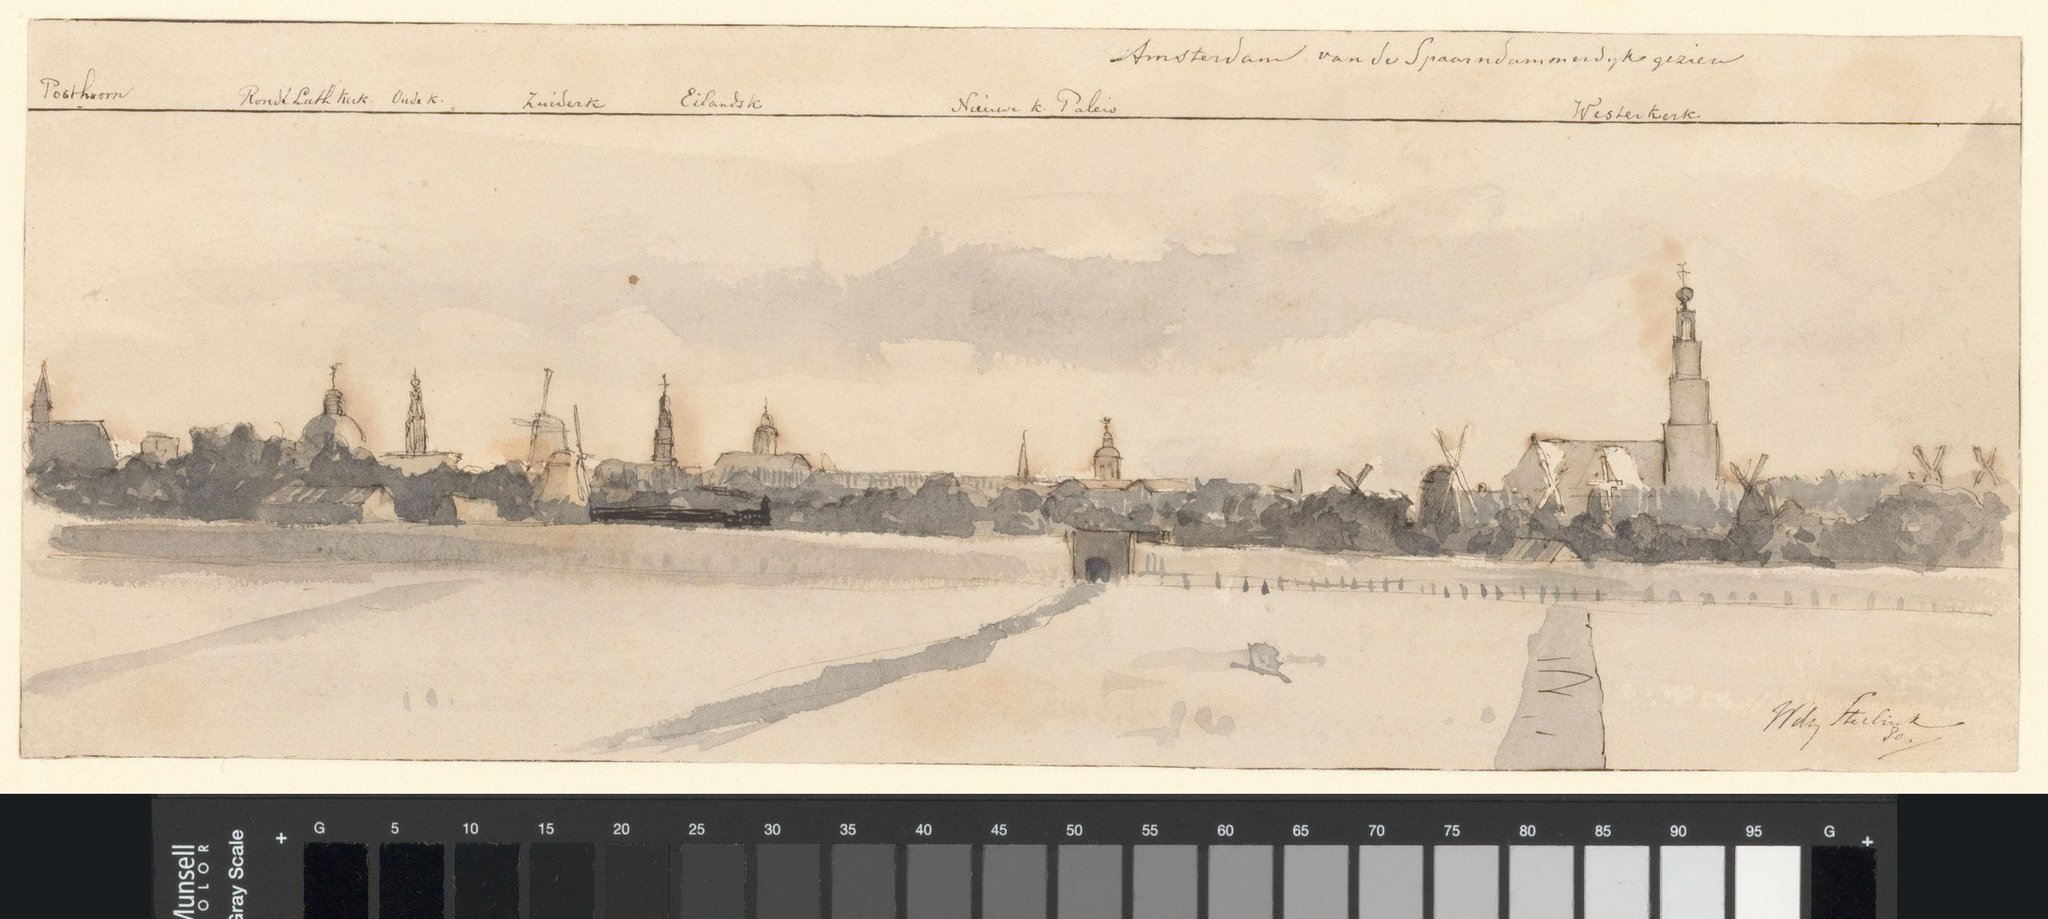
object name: drawing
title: Gezicht vanaf de Spaarndammerdijk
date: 1880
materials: ink, paper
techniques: brush, pen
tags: tower, clock tower ~ monumental adornment, city-view in general; 'veduta', dikes, levee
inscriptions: inscription: ‘Amsterdam van de (...) Paleis / Wester kerk’, signature and date: ‘Wilm Steelink / 80.’, inscription: ‘Port. 2’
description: Onderwerpsrubriek binnen de Atlas Amsterdam: Gezichten van het IJ op het westelijk gedeelte der stad, Blauwhoofd tot Nieuwebrug.